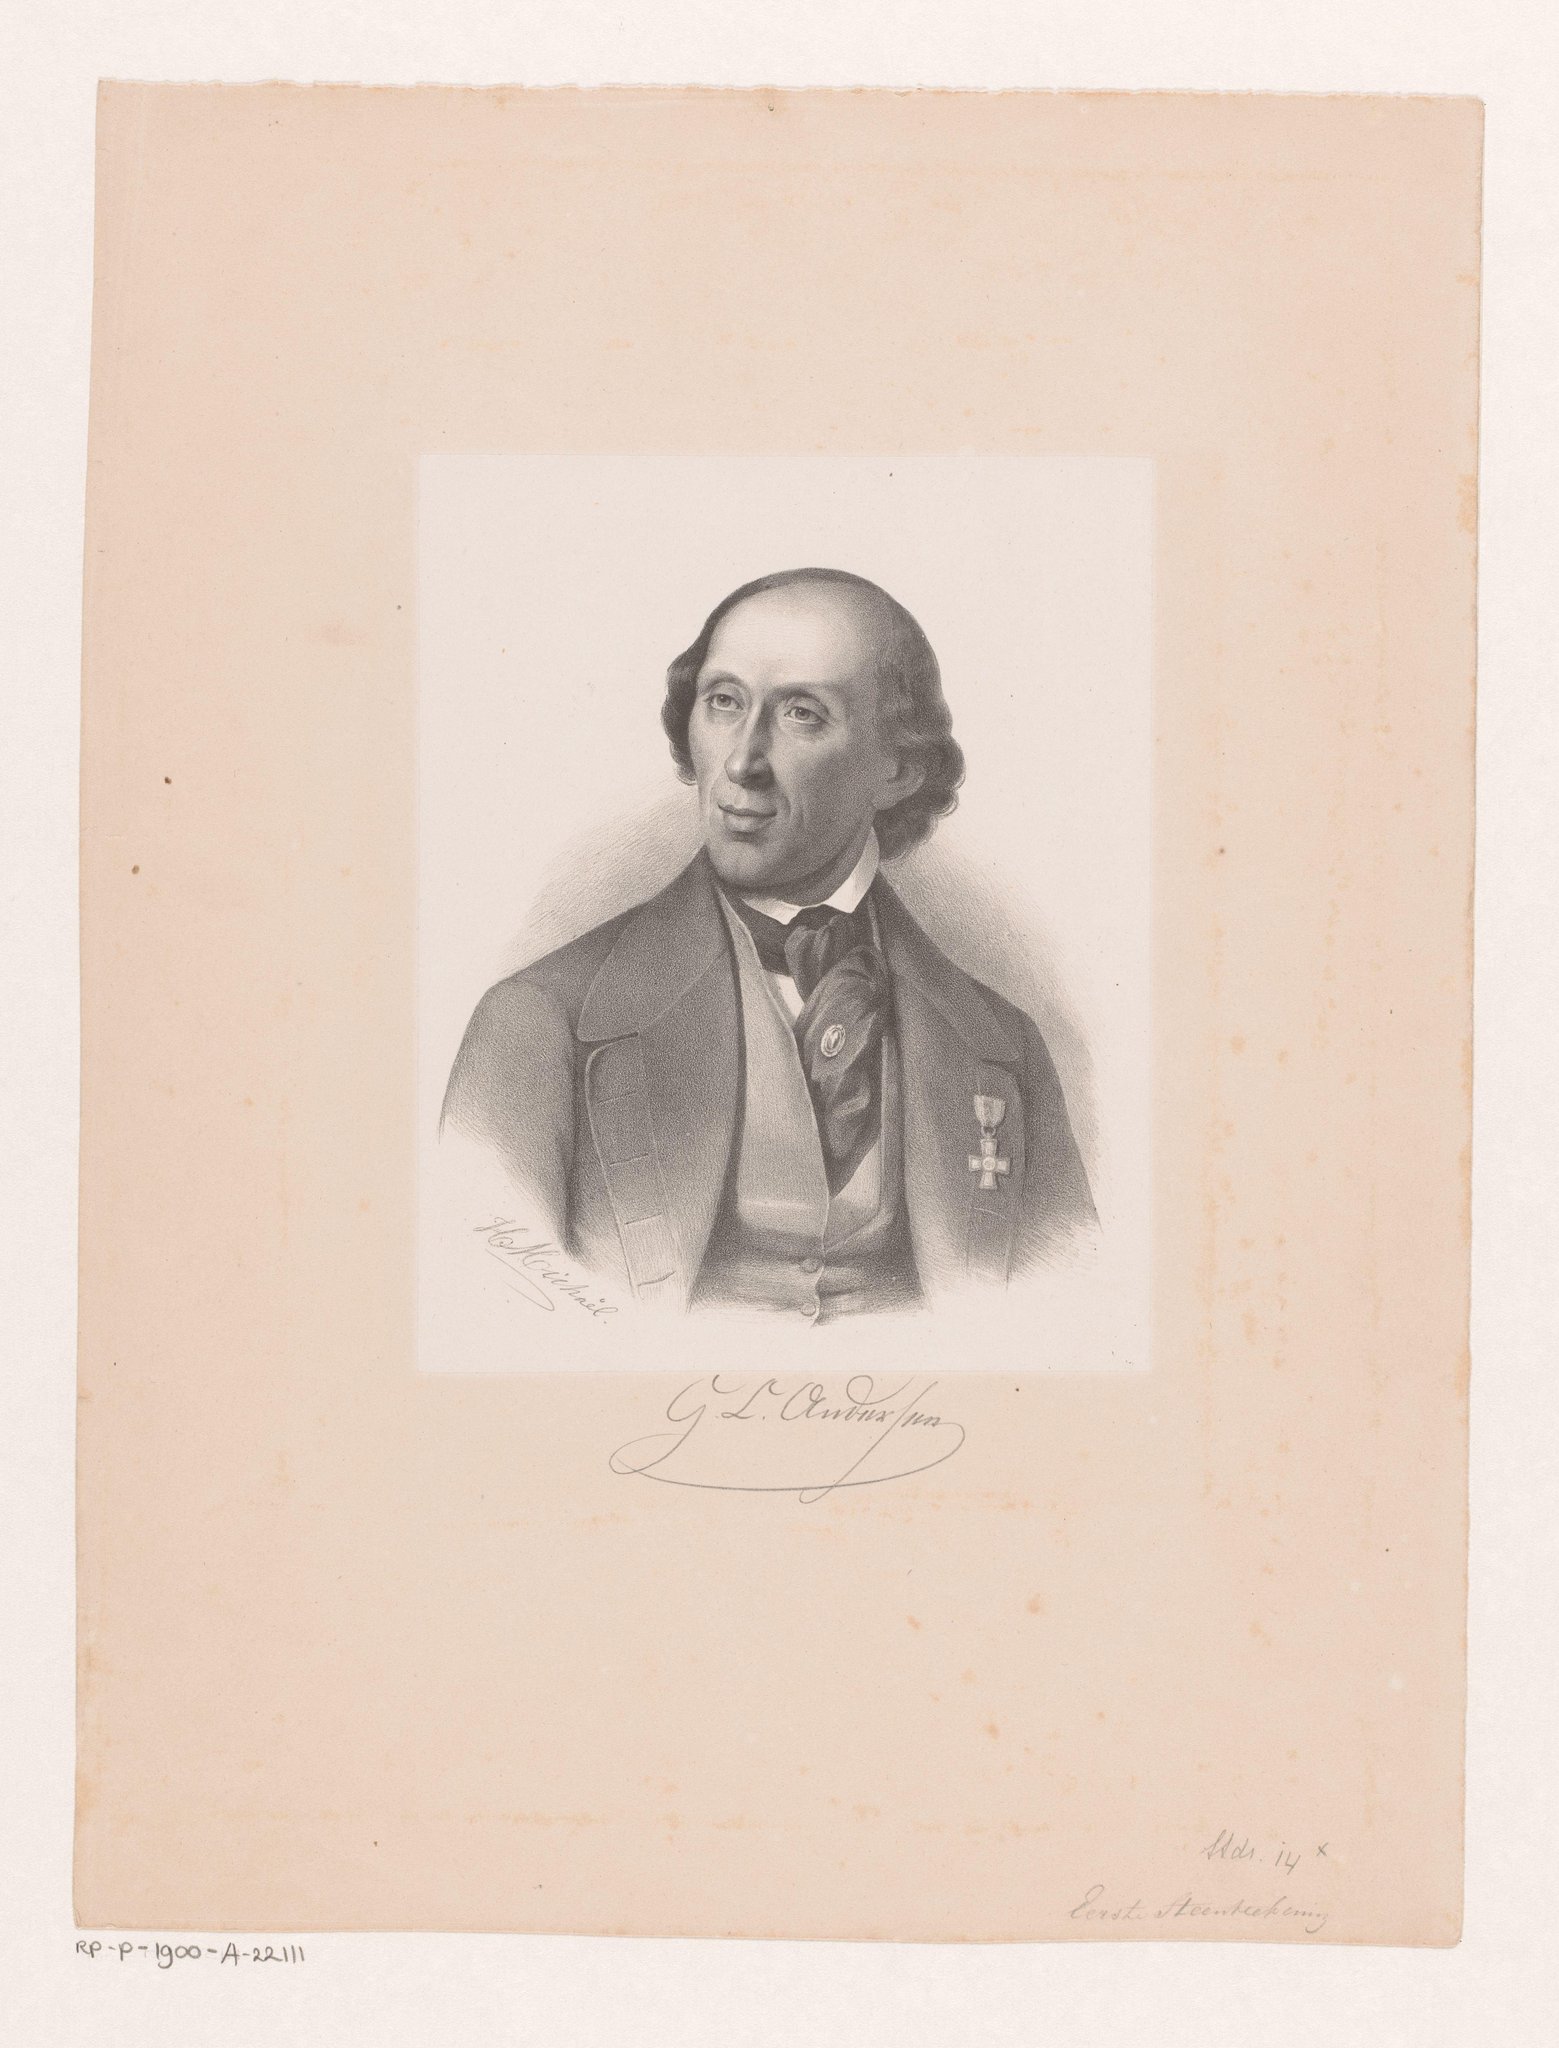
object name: print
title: Portret van Hans Christian Andersen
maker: hendrikus michael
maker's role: print maker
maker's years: 1814-1849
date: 1824-1849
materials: paper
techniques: lithograph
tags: hans christian andersen, historical persons (+ (full) bust portrait)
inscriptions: signature: ‘G. L. Andersen’, inscription: ‘Eerset steenteekening’, collector's mark: Lugt 2228